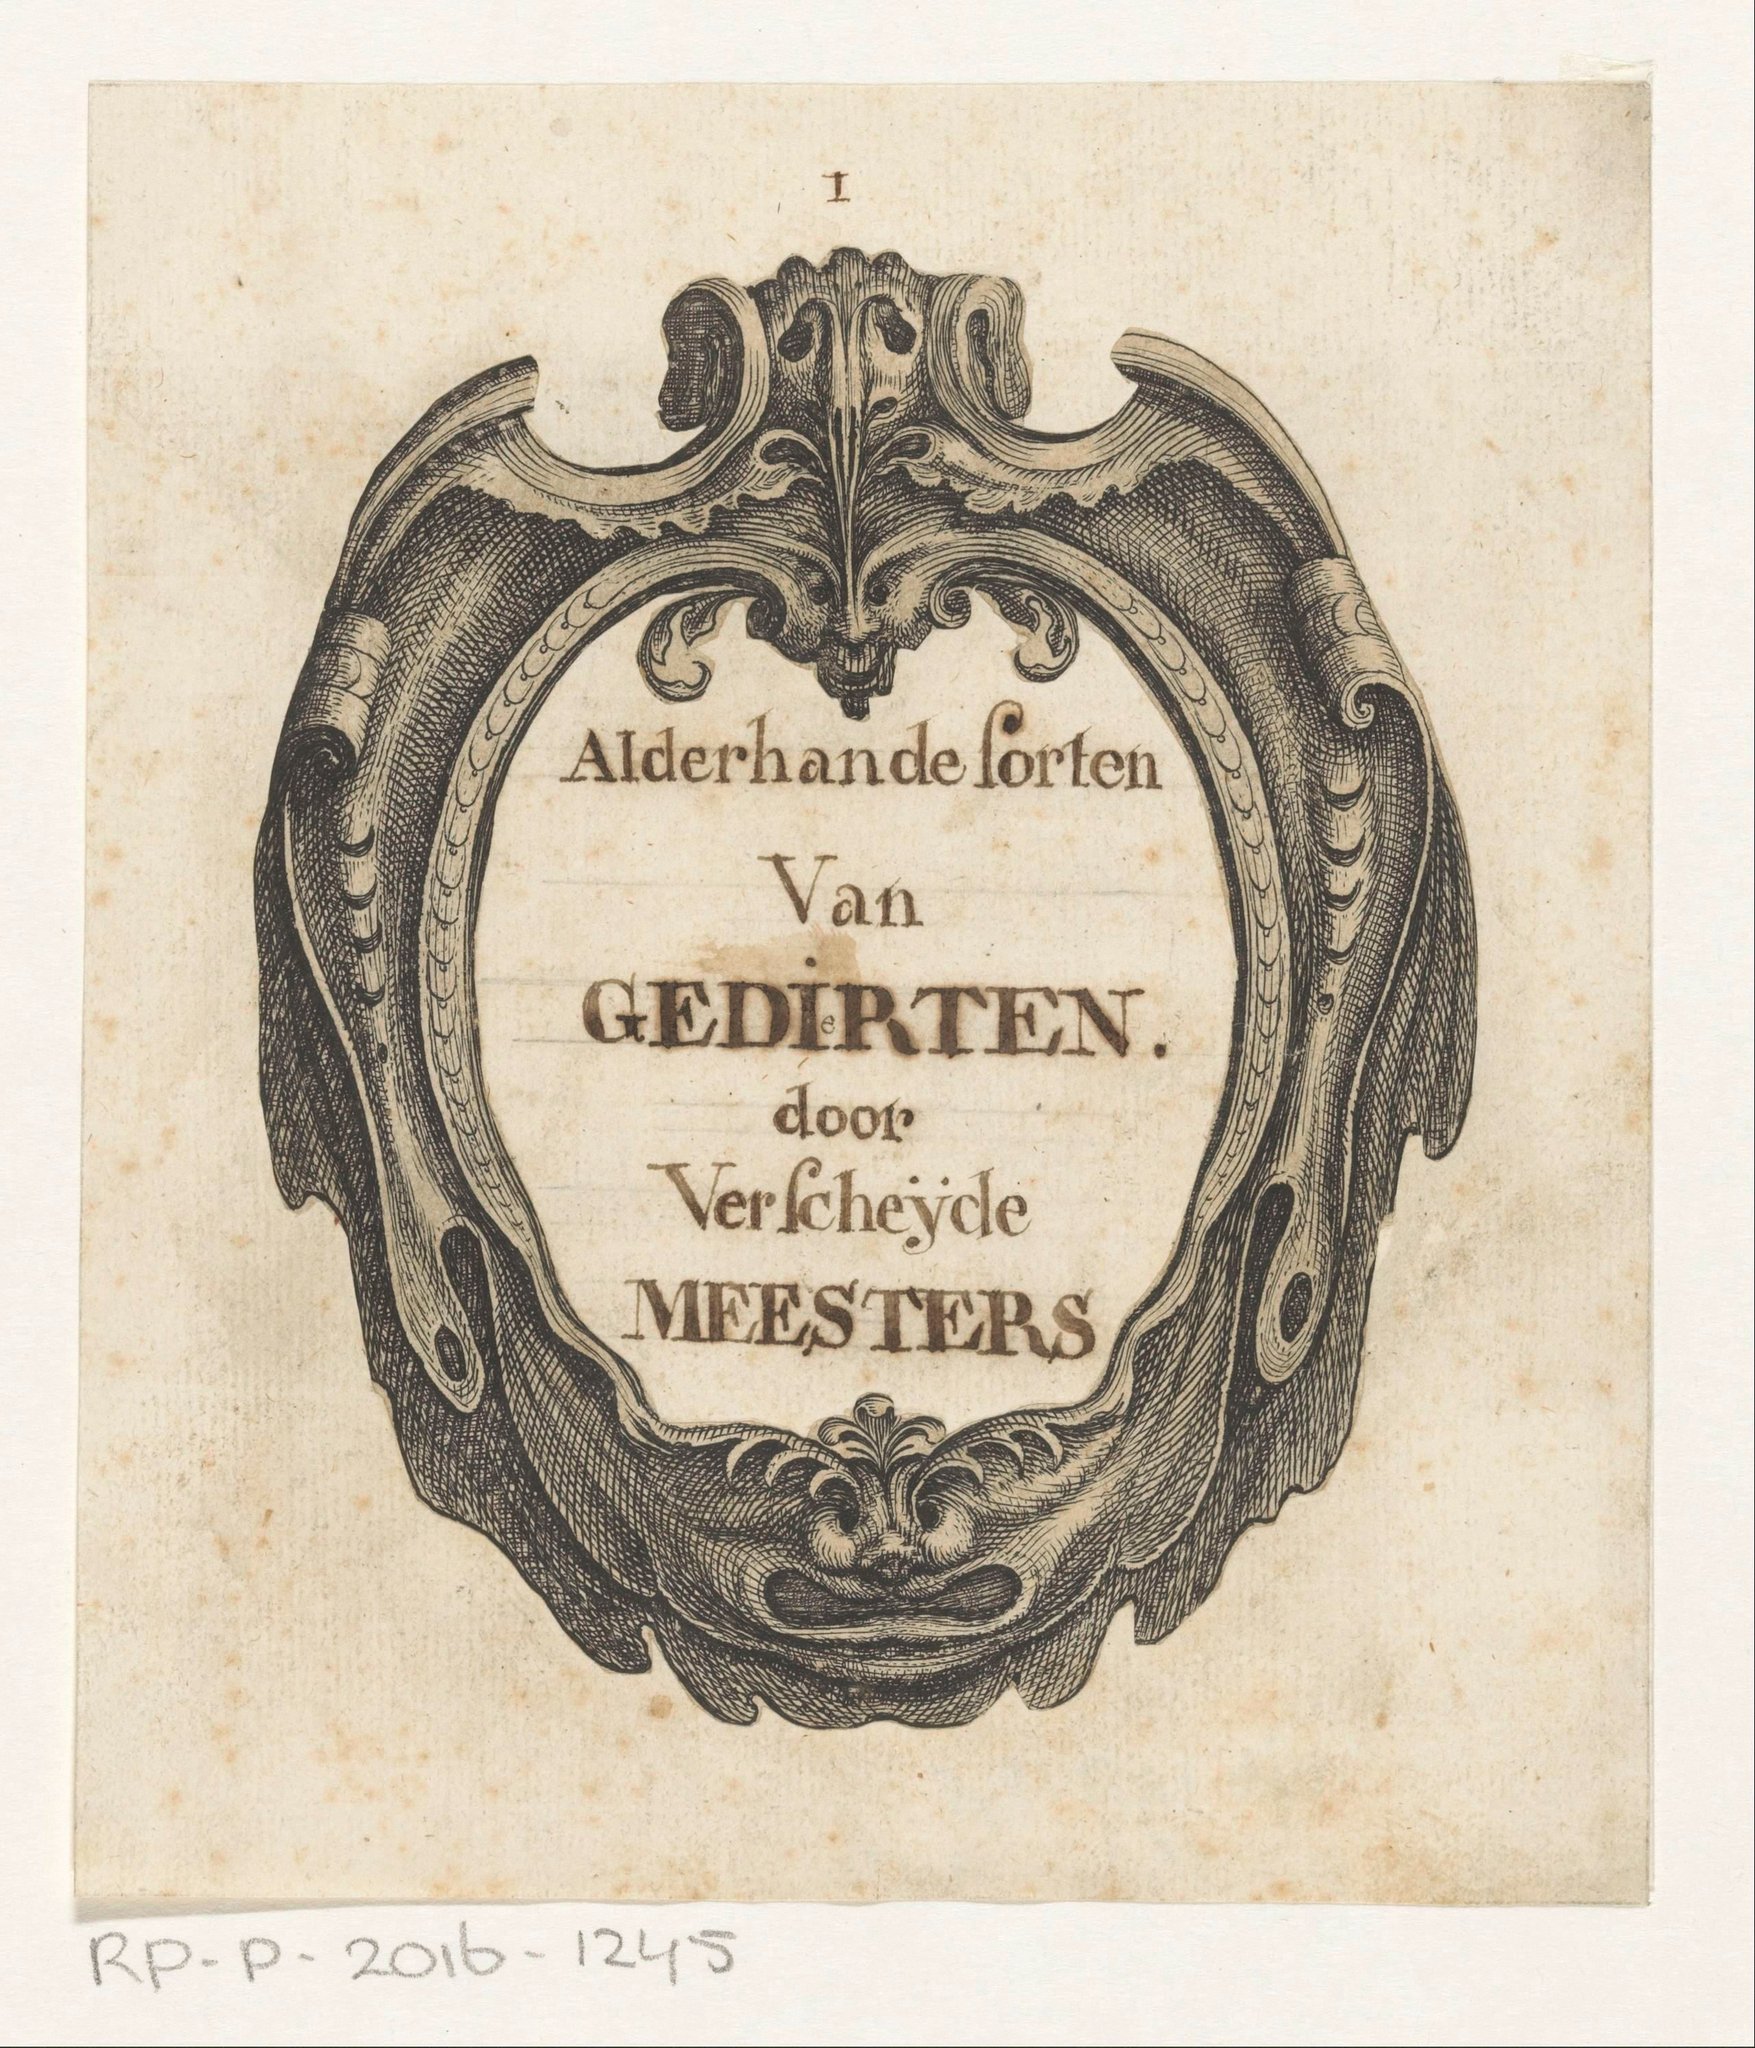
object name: print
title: Alderhande sorten Van Gedirten. door Verscheyde Meesters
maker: Anonymous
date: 1700-1800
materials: ink, paper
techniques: etching, pen, writing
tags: ornament ~ cartouche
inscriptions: collector's mark: Lugt 2228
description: Cartouche met aan boven- en onderzijde een masker. In het midden de handgeschreven titel. Midden boven I genummerd.